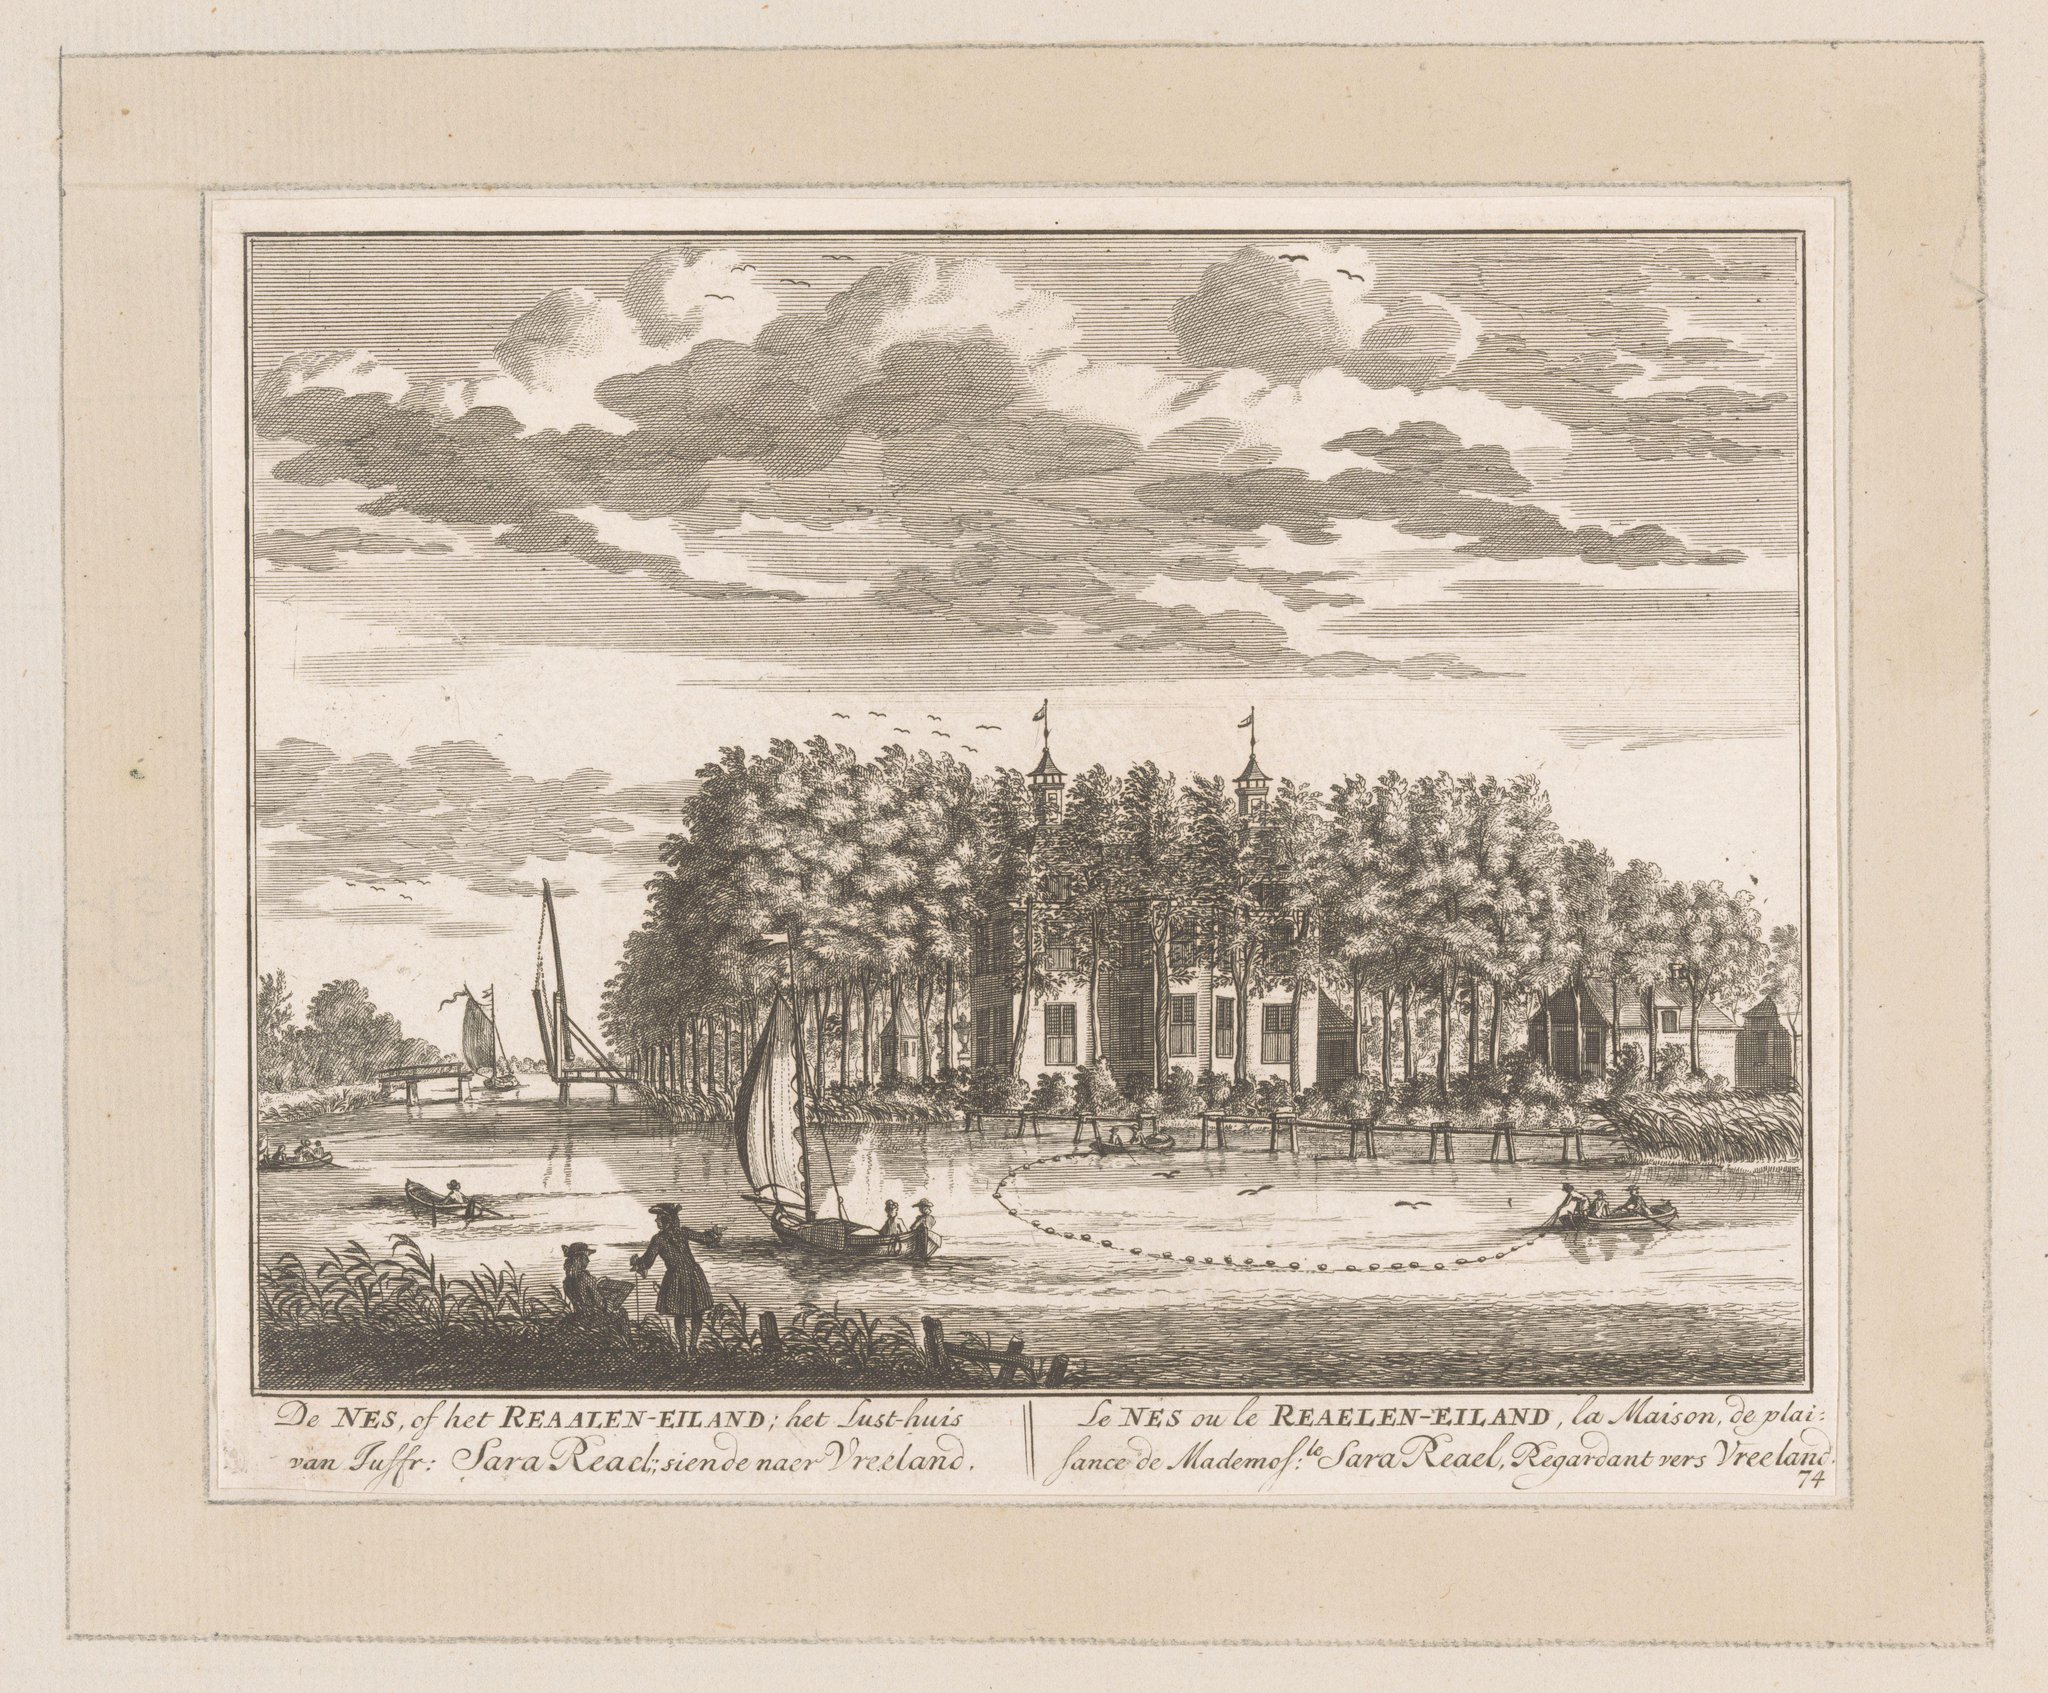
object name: print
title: De Nes, of het Reaalen-eiland; het lust-huis van juffr. Sara Reael; siende naer Vreeland / Le Nes ou le Reaelen-eiland, la maison de plaisance de mademos.le Sara Reael, regardant vers Vreeland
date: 1719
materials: paper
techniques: engraving, etching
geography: amsterdam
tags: sailing-ship, sailing-boat, fishing net, rowing-boat, canoe, etc.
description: Prent uit: Leth, Andries de. De Zegepraalende Vecht (...). Amsterdam: Weduwe Nicolaes Visscher, 1719, pl. 74. Later ook uitgegeven in: Brouërius van Nidek, Matthaeus. De Vechtstroom, van Utrecht tot Muiden (...). Amsterdam: H. Gartman, W. Vermandel en J.W. Smit, 1790.